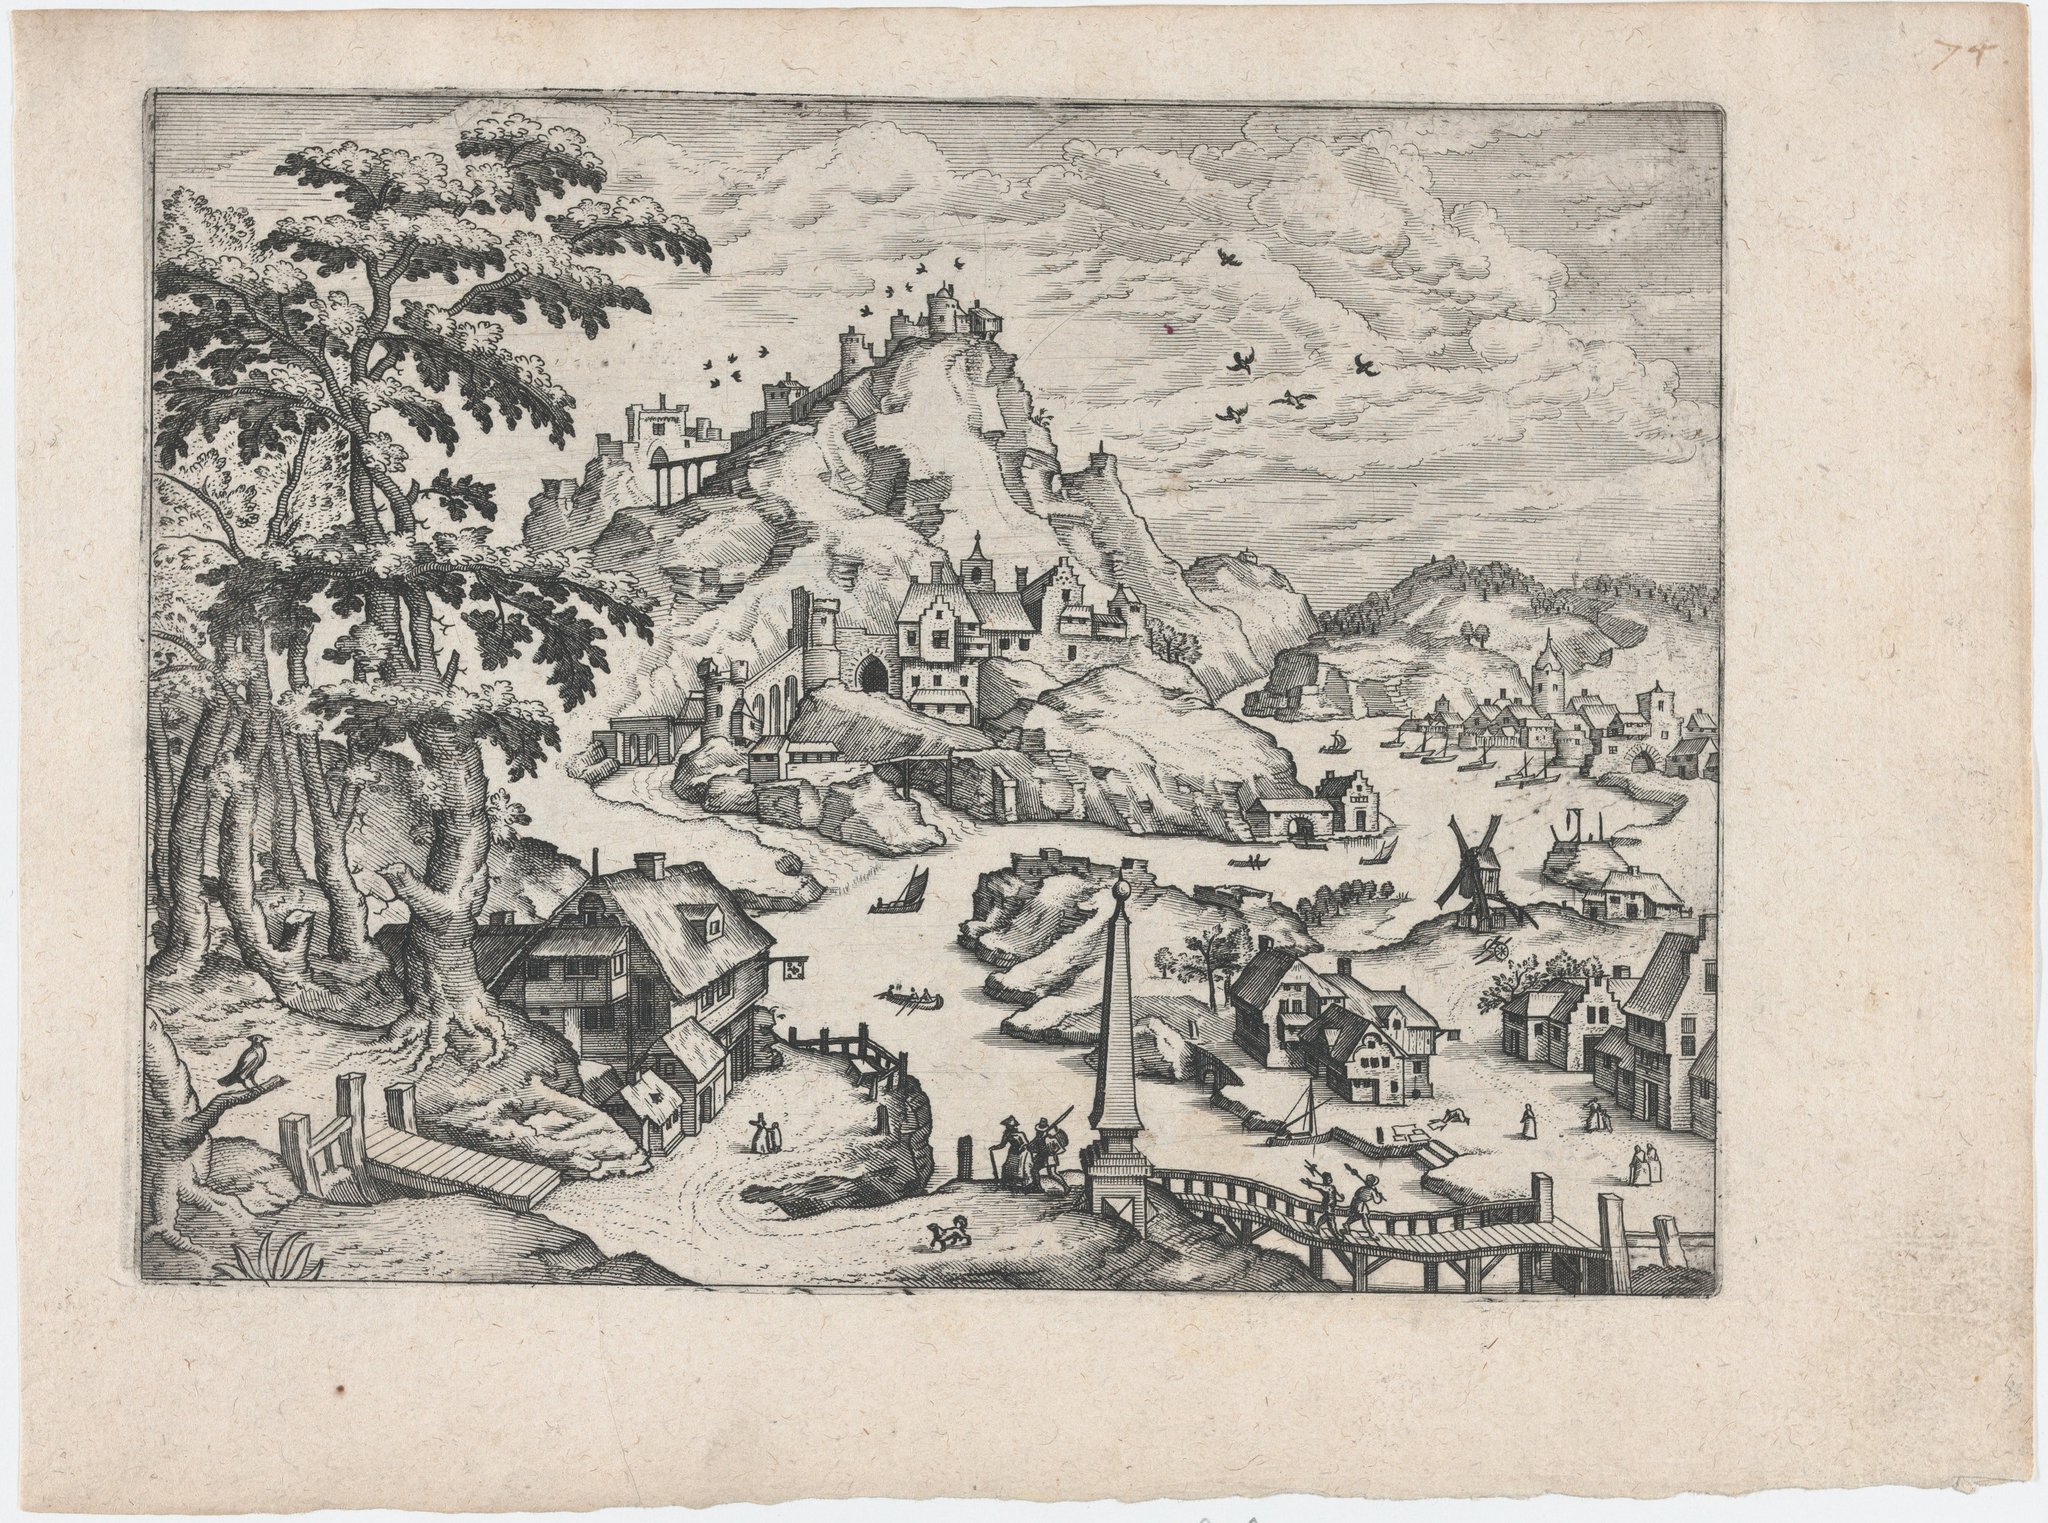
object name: print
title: River Valley with Obelisk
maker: lucas gassel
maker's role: artist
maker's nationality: netherlandish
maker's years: 1495-1500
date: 1560-1570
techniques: engraving, etching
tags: houses,obelisks,bridges,rivers,mountains